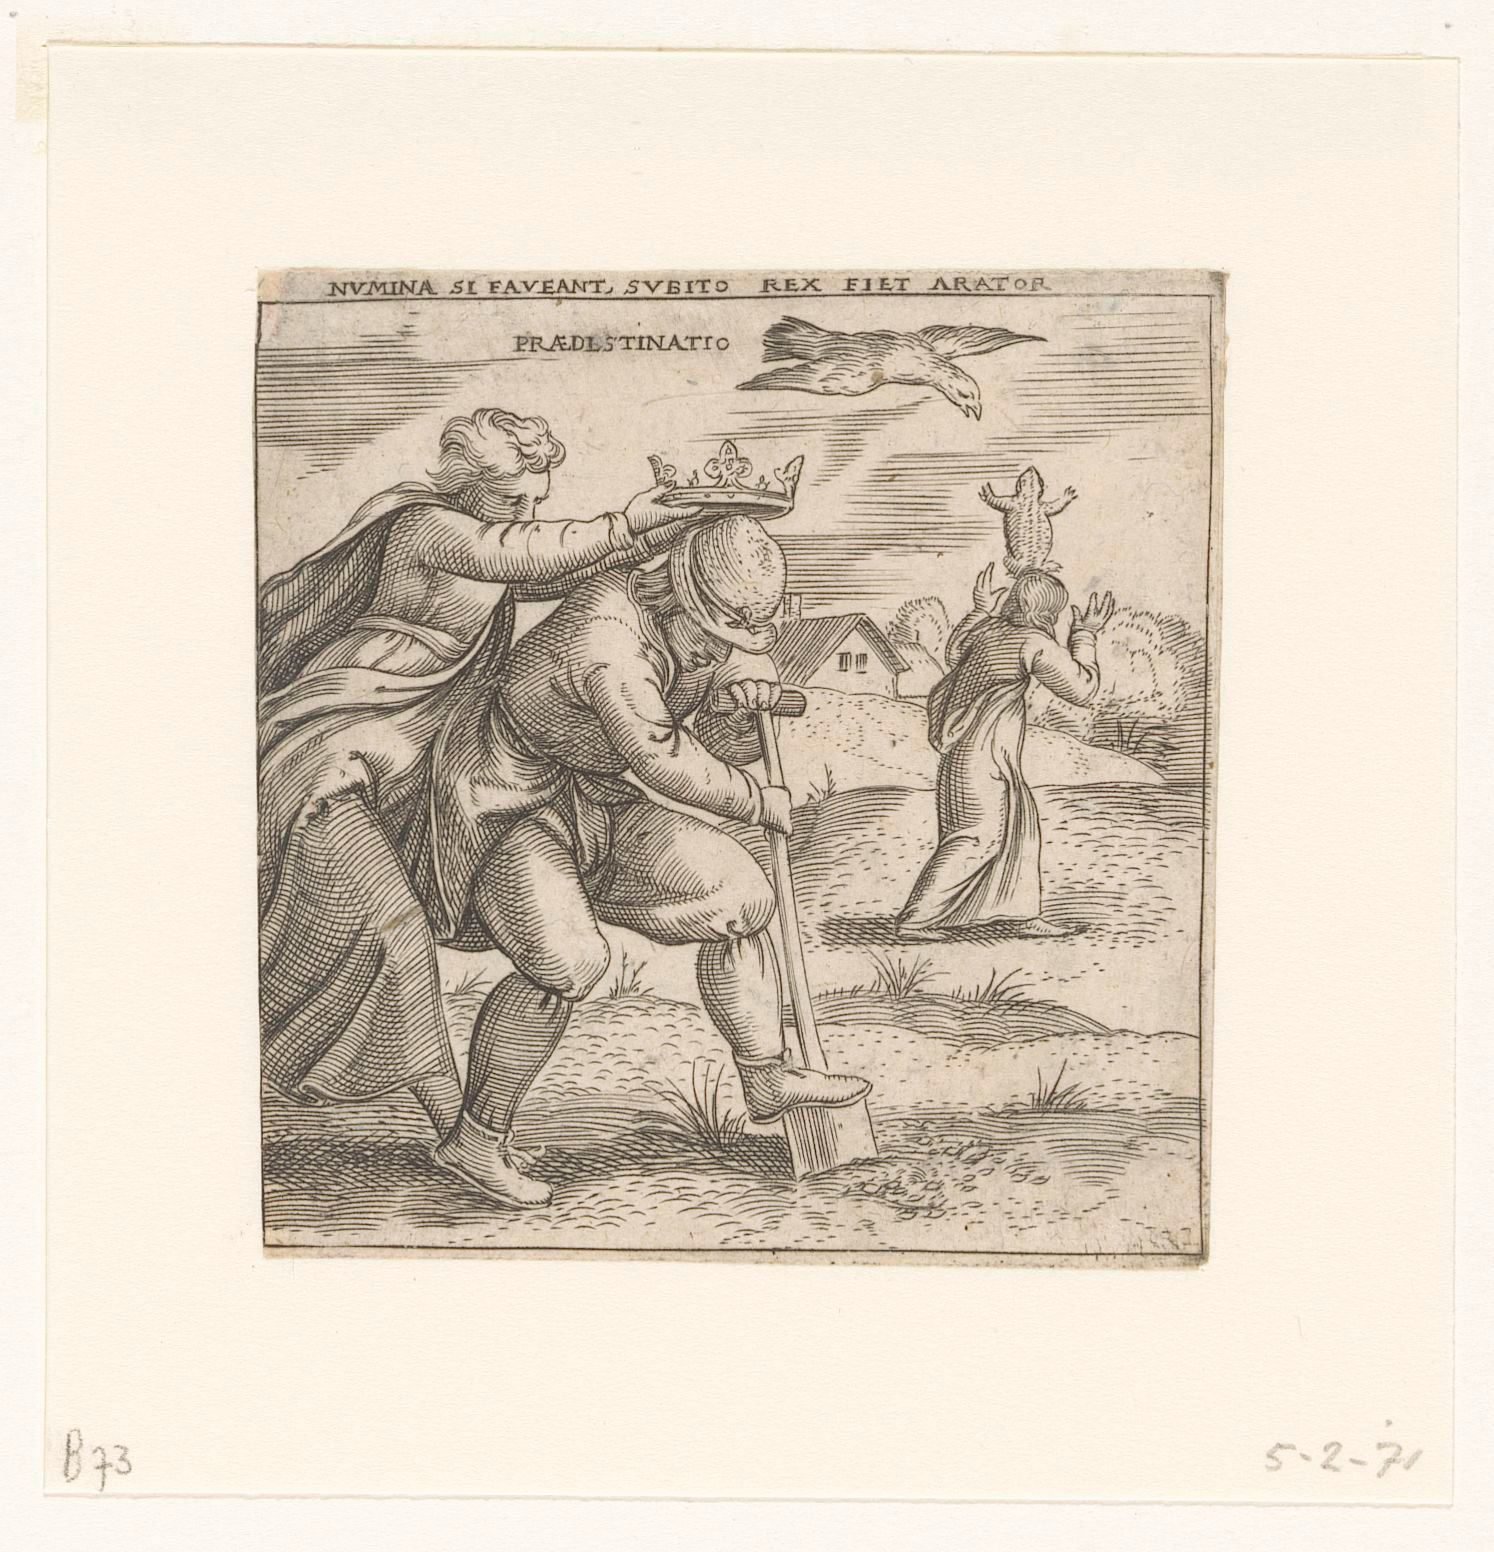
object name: print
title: Emblematische figuren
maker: francesco salviati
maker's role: draughtsman, painter, print maker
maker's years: 1510-1563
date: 1533-1567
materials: paper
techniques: engraving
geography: italy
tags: tailless amphibians: frog, crown (symbol of sovereignty), predatory birds: eagle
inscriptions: collector's mark: ‘RIJKS / MUSM’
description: Een man werkend op het land, achter hem een vrouw die een kroon boven zijn hoofd houdt. Rechts vliegt een adelaar boven een vrouw met een kikker op haar hoofd. Bovenaan een regel Latijnse tekst.